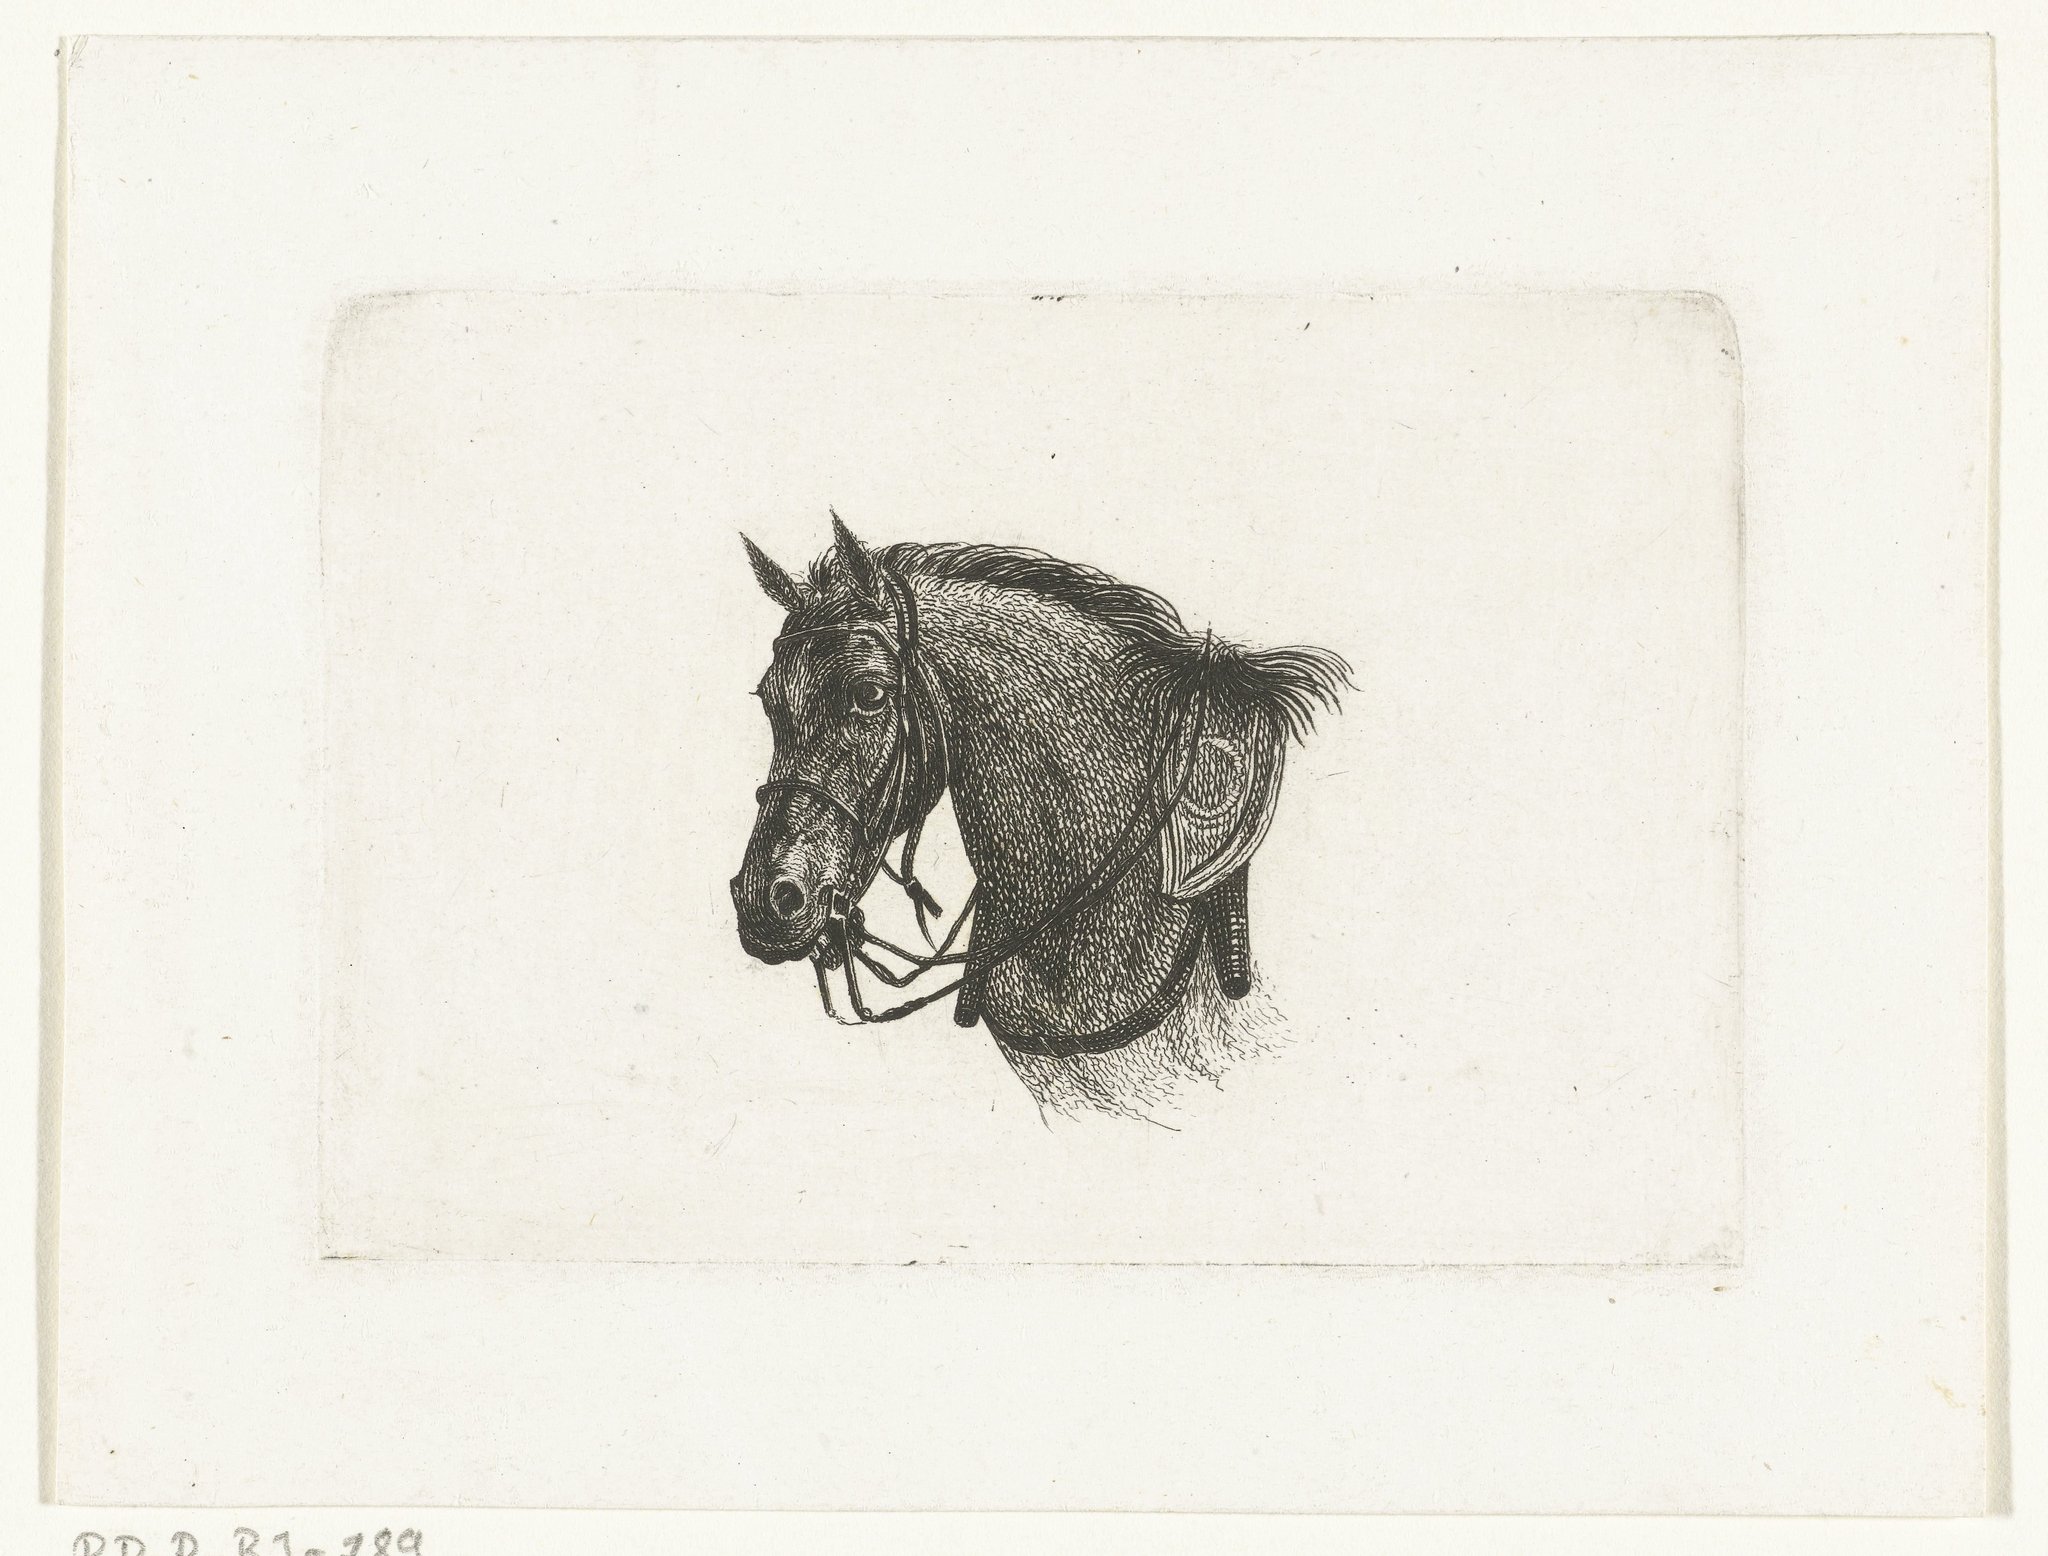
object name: print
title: Paardenhoofd in lichtgebogen houding, naar links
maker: joannes bemme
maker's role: print maker, printer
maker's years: 1775-1841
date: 1800-1841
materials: paper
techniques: etching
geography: rotterdam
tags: horse (+ head of an animal)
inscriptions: collector's mark: Lugt 2165